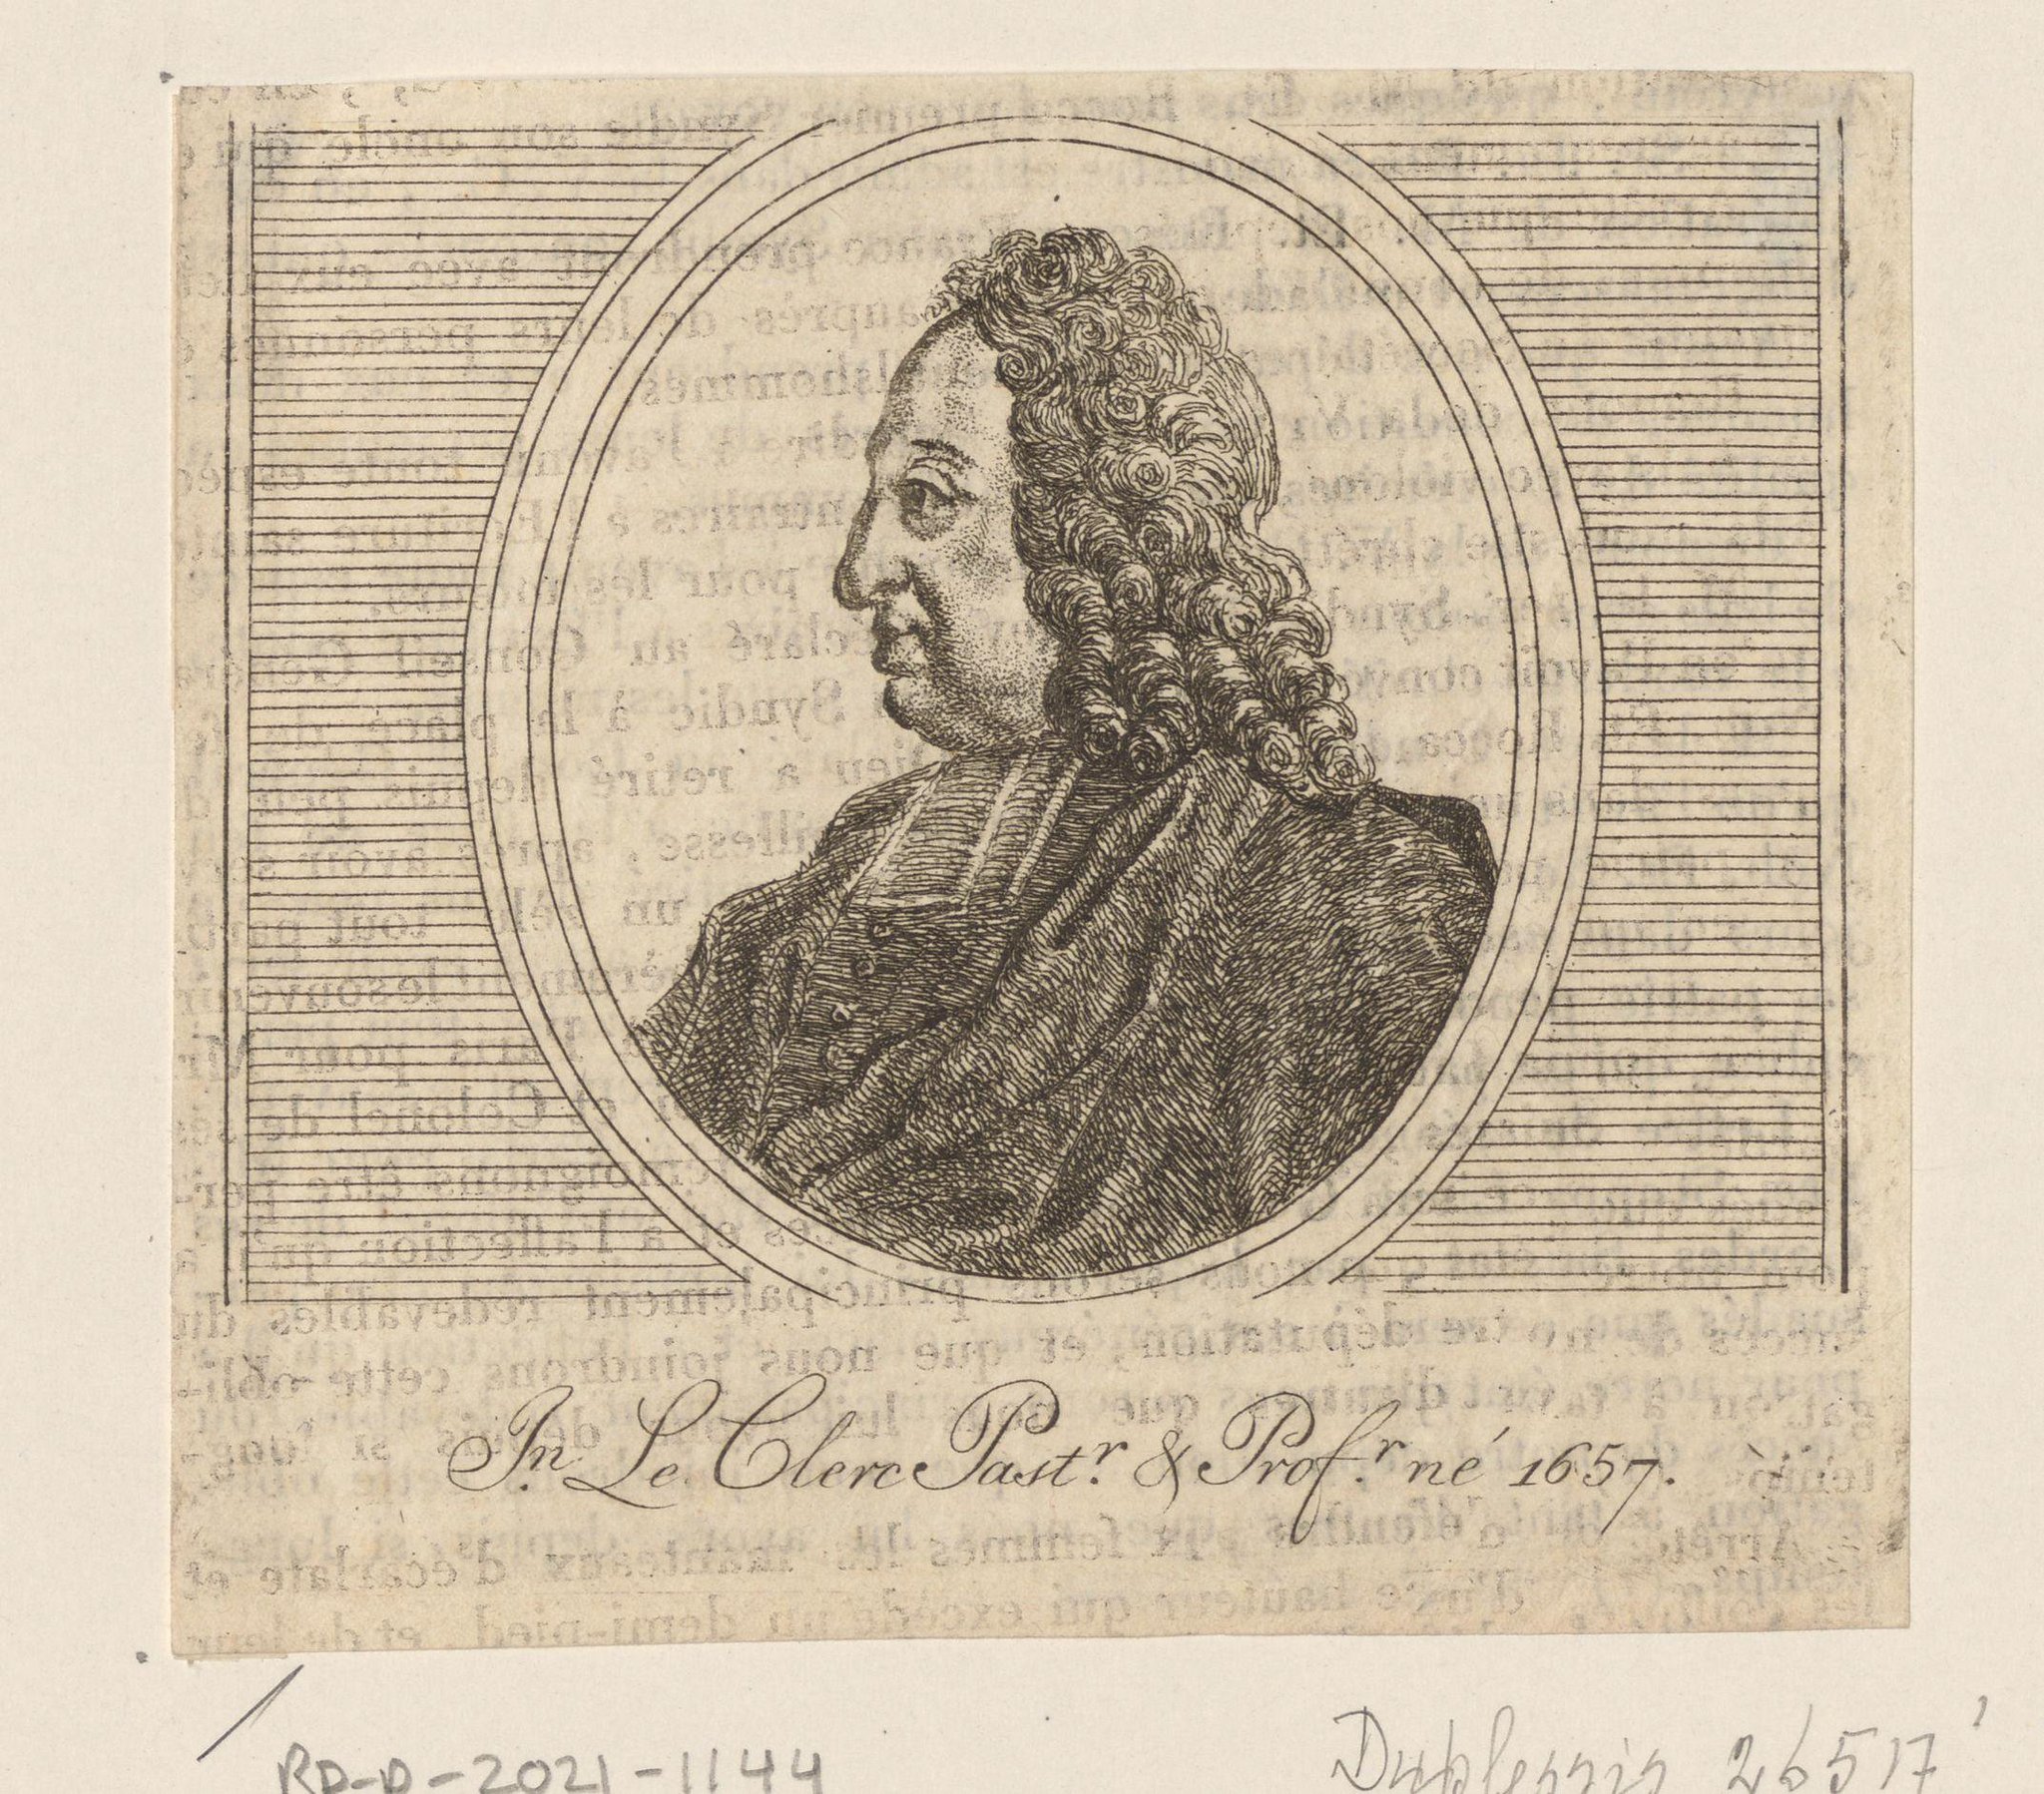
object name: book illustration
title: Portret van Jean le Clerc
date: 1815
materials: paper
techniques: etching, letterpress printing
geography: geneva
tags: jean le clerc (1657-1736), theologian, historical persons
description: Prent uit: Fragmens biographiques et historiques (...). Genève: Manget & Cherbuliez, 1815, p. 213.